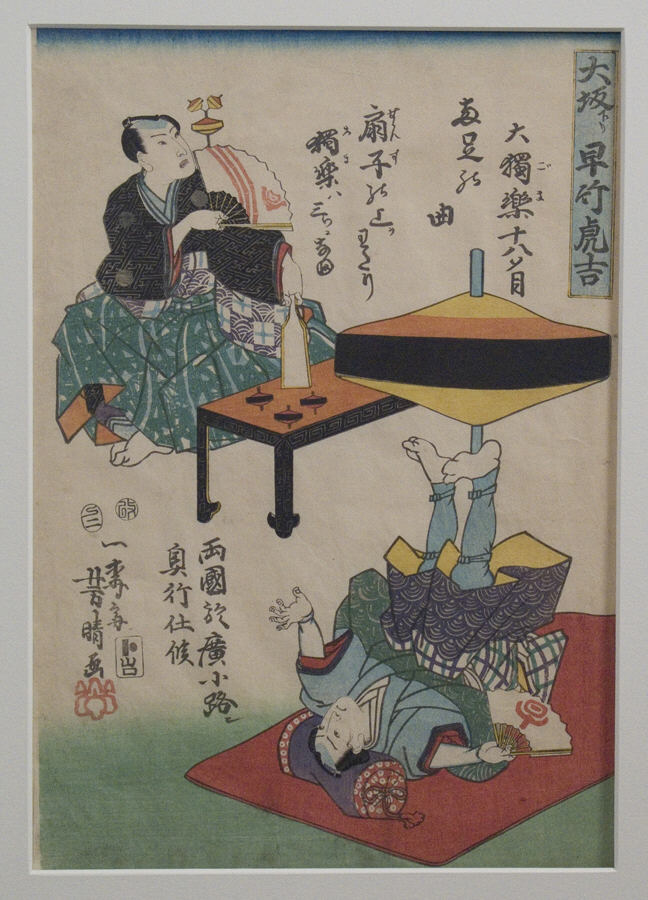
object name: print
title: Hayatake Torakichi from Osaka: Spinning Tops in Ryogoku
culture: japanese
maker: utagawa yoshiharu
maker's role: artist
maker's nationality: japanese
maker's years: 1828-1888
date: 1857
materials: ink, paper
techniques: woodblock print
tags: men,acrobats,toys